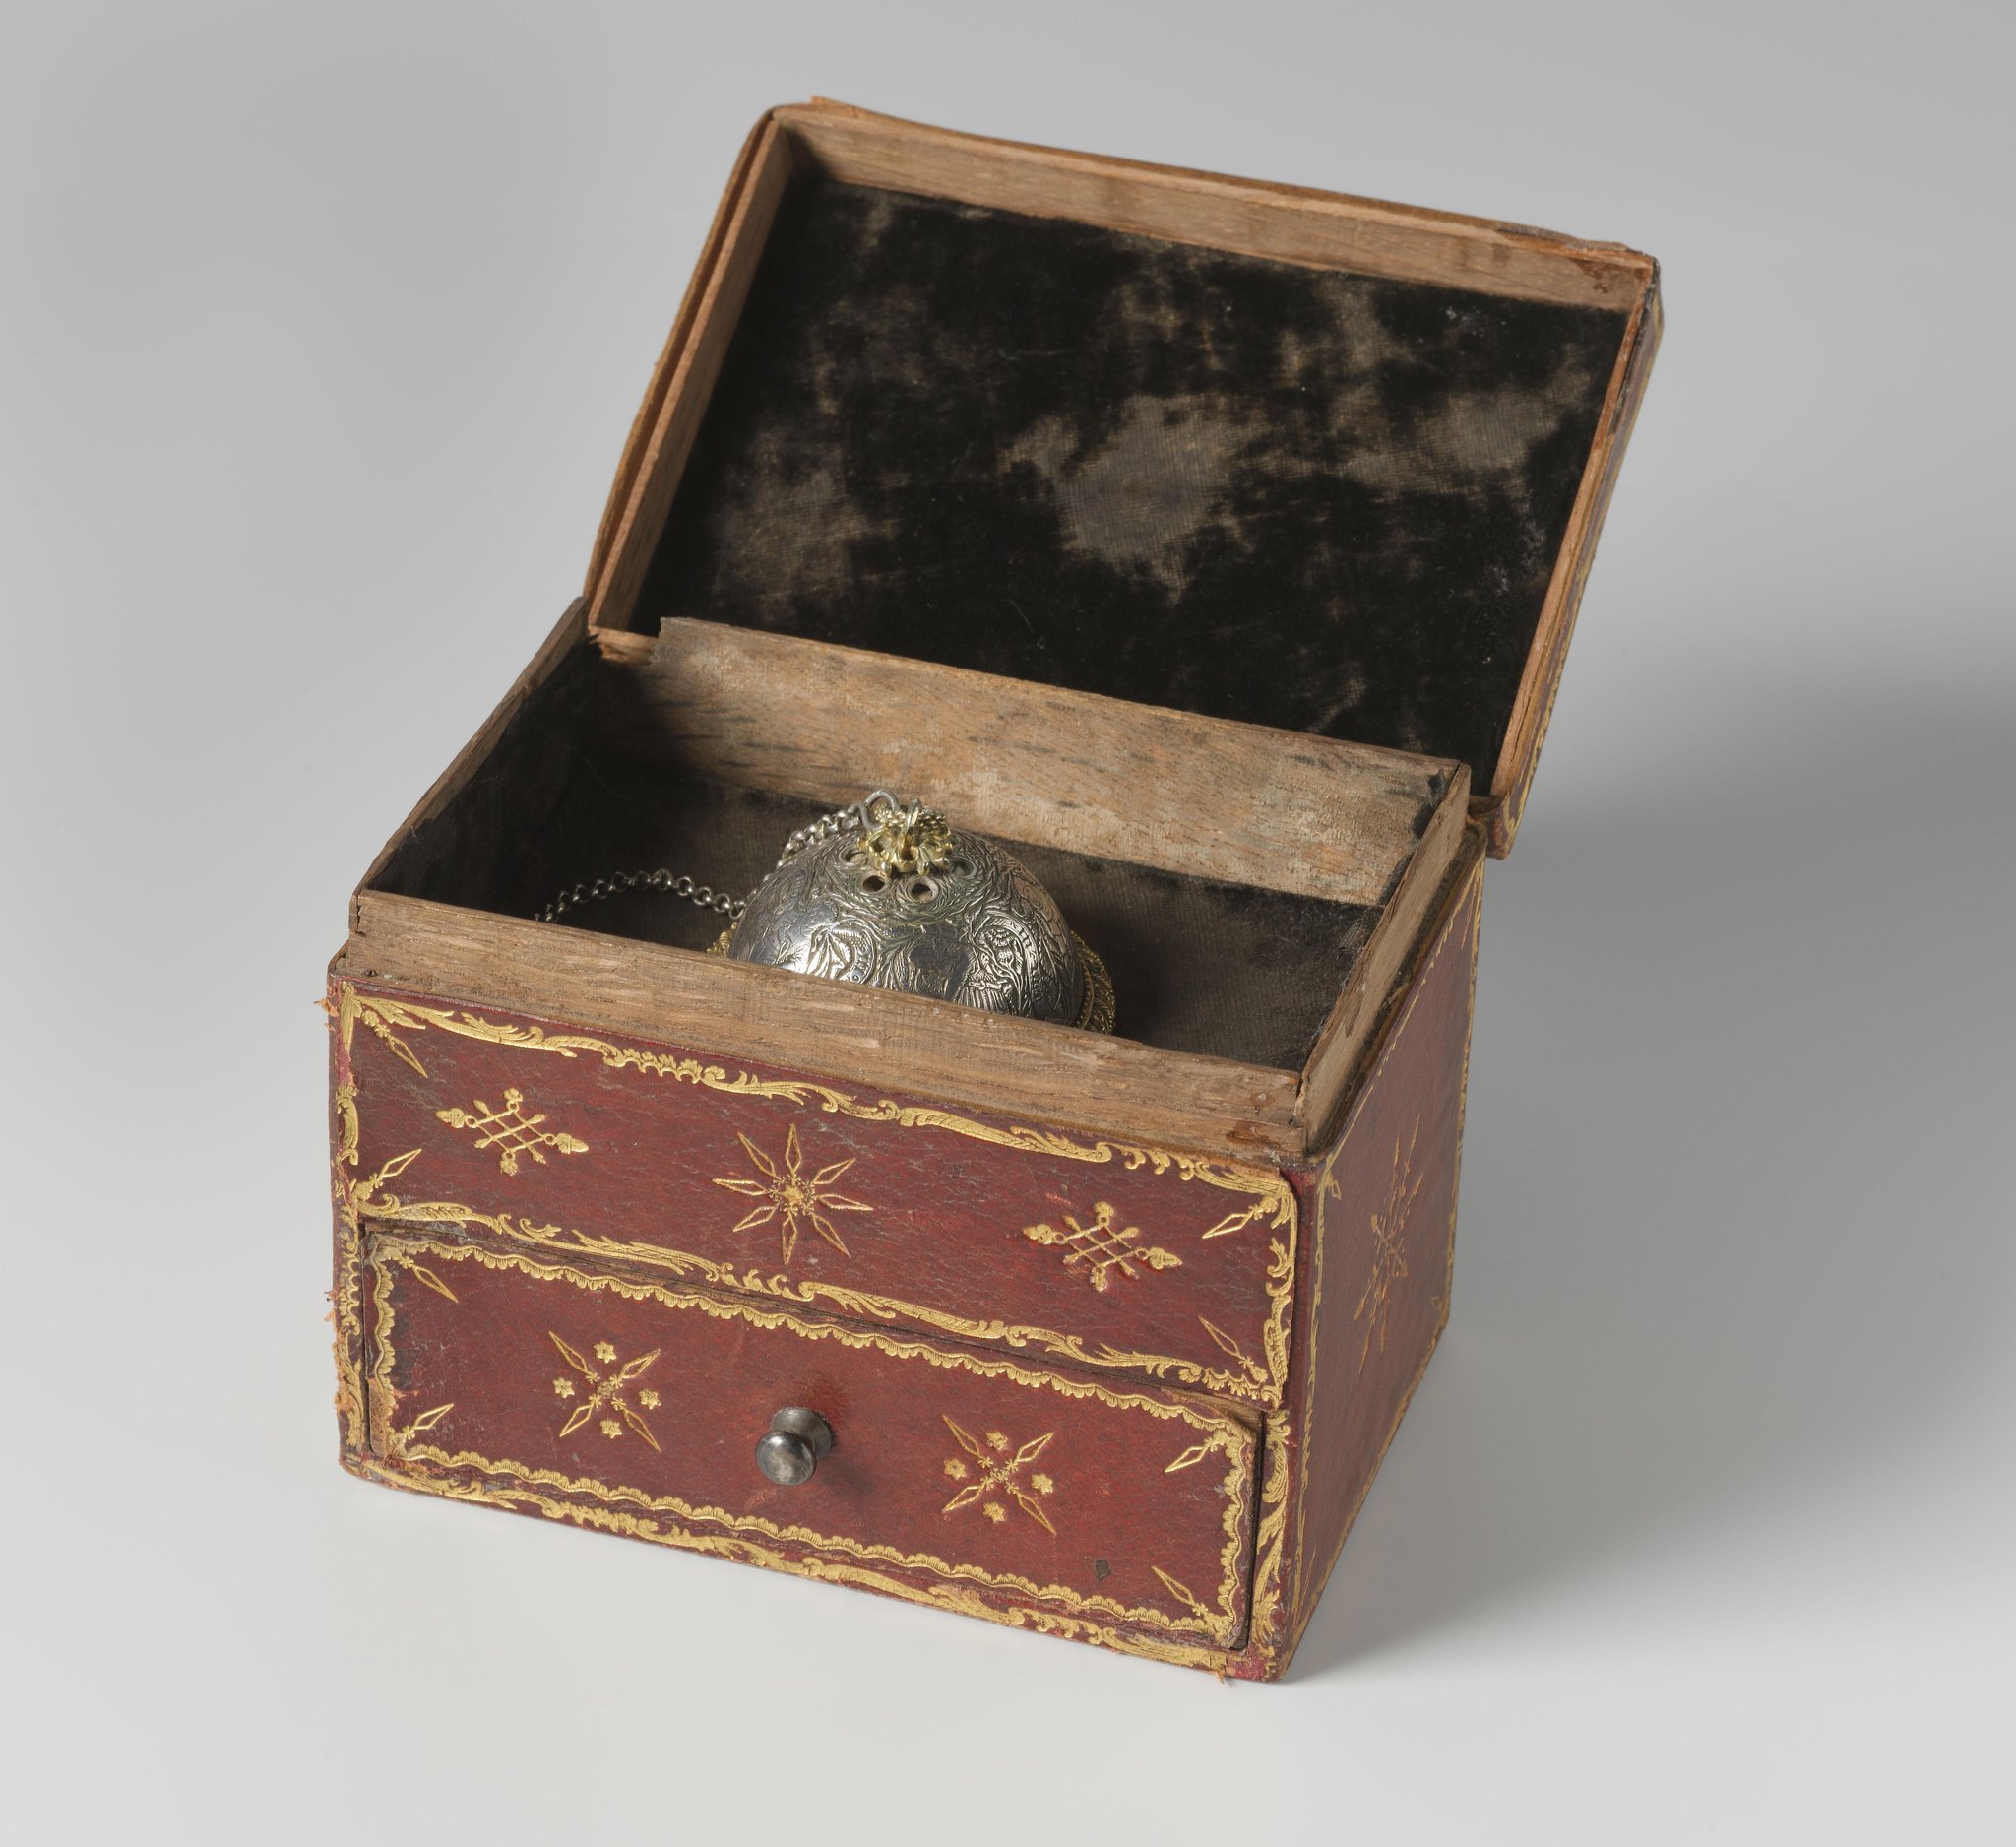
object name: letter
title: Prayer Nut in Original Casing, with Box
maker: adam dircksz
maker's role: goldsmith, sculptor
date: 1500-1530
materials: wood, gold, leather, paper, silver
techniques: engraving, carving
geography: delft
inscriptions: inscription, on the outside of the silver housing, on an interrupted banderol, engraved: ‘SOKET · VAER · / GHI · VILT · HIER · VINDET / · IN · D ARDE / · IN · VUER · / · IN · VATER / INDEN · LUCHT’, silver mark, on the smooth edge of the half of the silver housing with the Nativity, stamped: unknown maker’s mark or assay mark: animal head (?), silver mark, on the smooth edge of the half of the silver housing with the Nativity, stamped: unknown maker’s mark or assay mark: serrated leaf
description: This tiny boxwood ball, mounted in silver, is incredibly finely carved. It is a ‘prayer nut’, intended to be hung from a belt or a rosary, and was meant as an aid to prayer. The owner moreover would certainly have enjoyed showing off such a superbly crafted and precious jewel. Seen at the top is the Nativity and at the bottom the Adoration of the Magi.